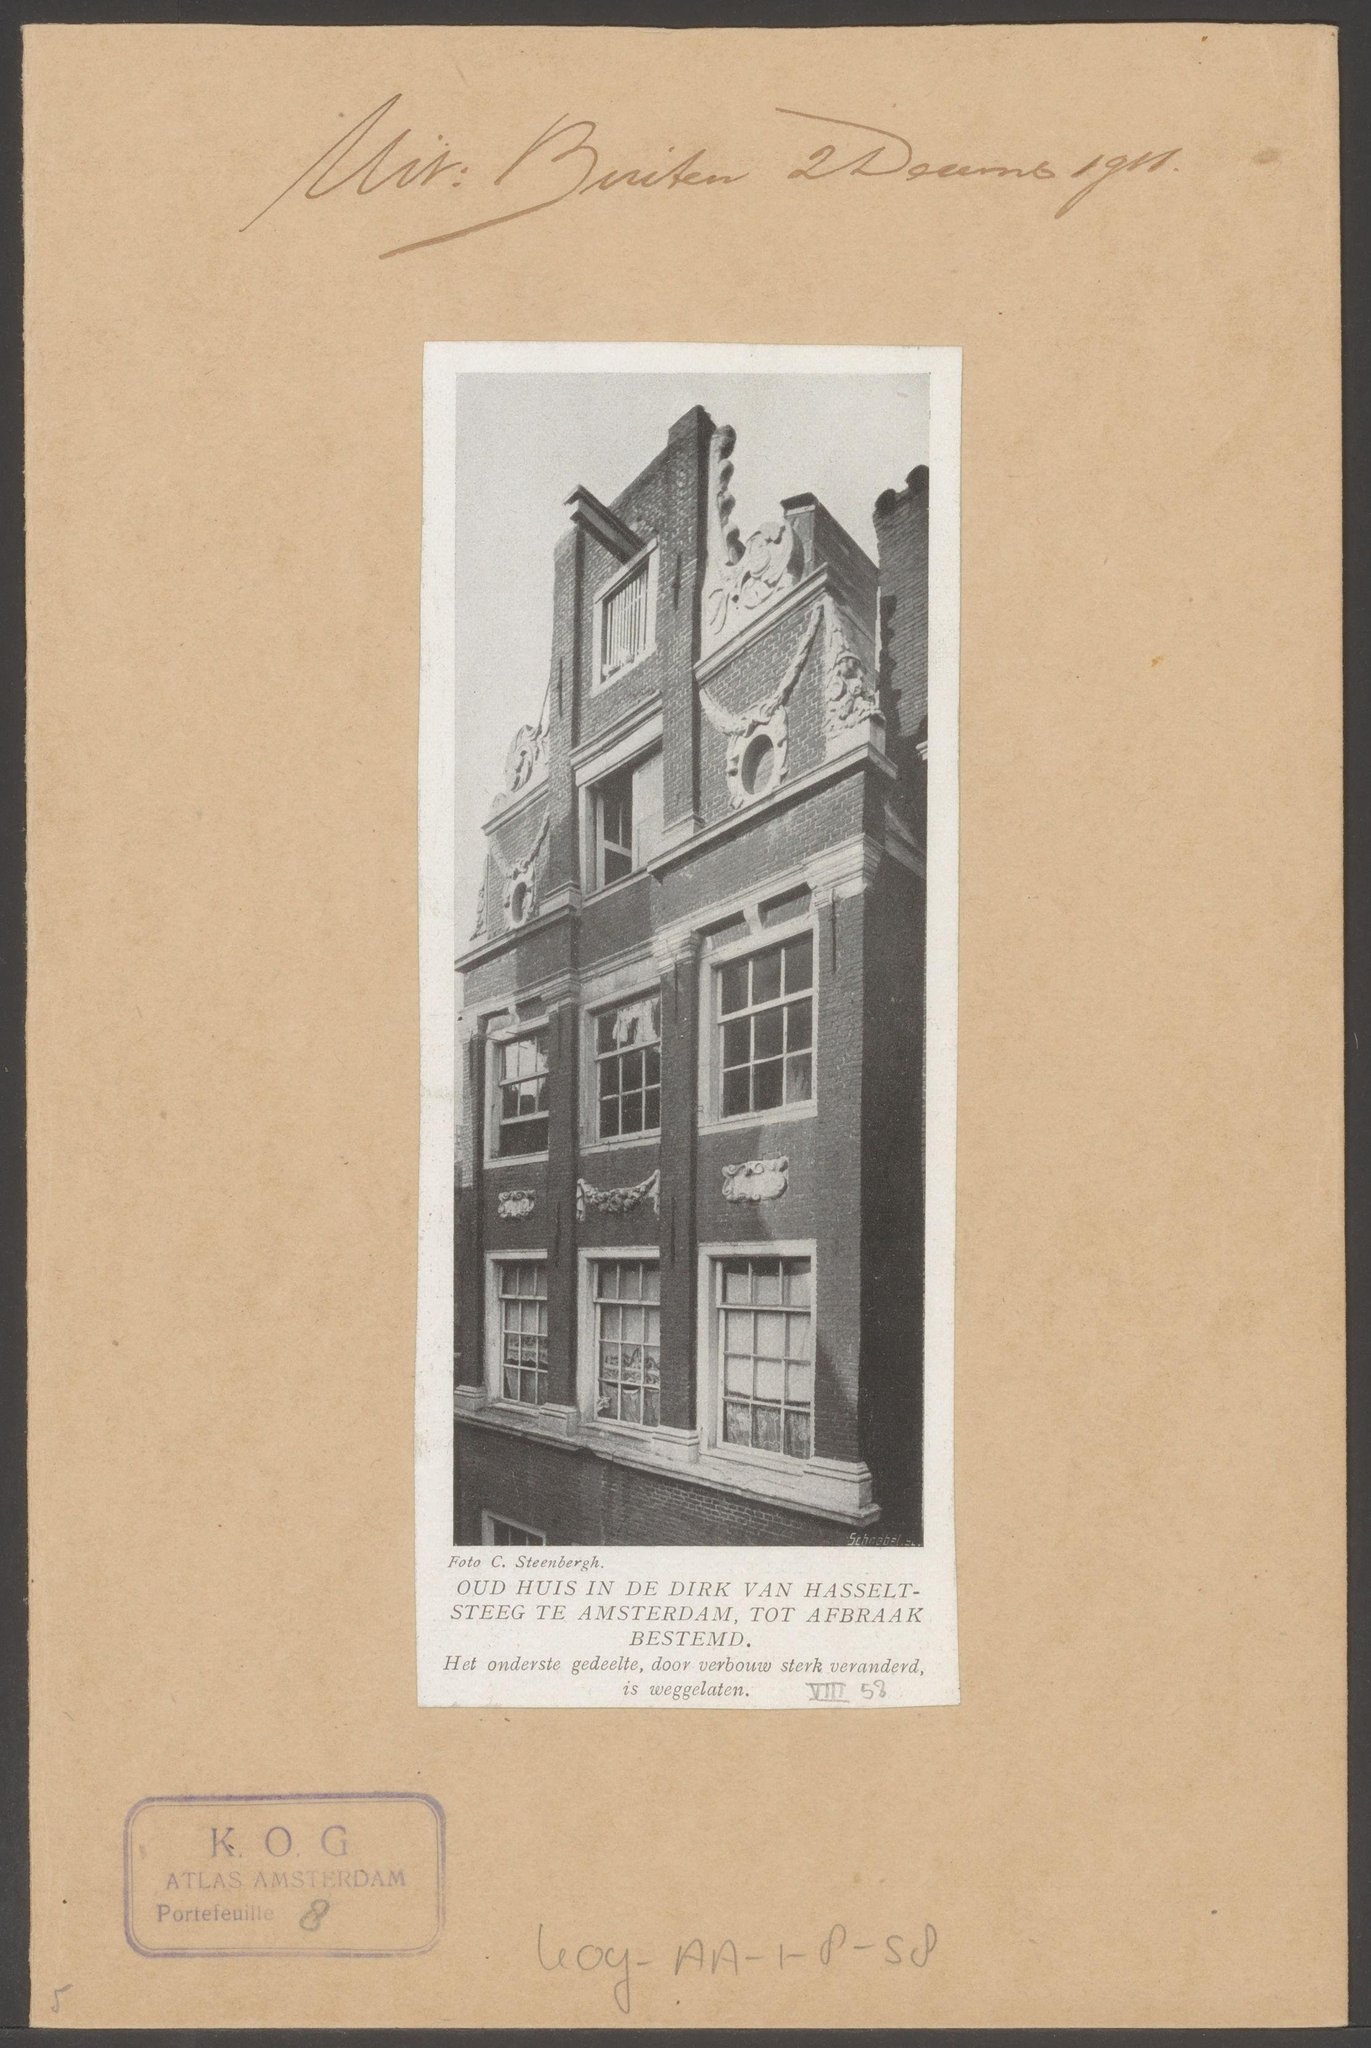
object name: photomechanical print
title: Gezicht op een pand in de Dirk van Hasseltsteeg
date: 1911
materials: paper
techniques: letterpress printing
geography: amsterdam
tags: city-view in general; 'veduta', the usual house or row of houses, façade (of house or building)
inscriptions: collector's mark: ‘8’ Lugt 1641b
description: Onderwerpsrubriek binnen de Atlas Amsterdam: Haarlemmerplein, Halvemaansteeg, Handboogstraat, Handelskade, Haringpakkerij, Hartenstraat, Hasseltsteeg (Dirk van), Heerengracht.